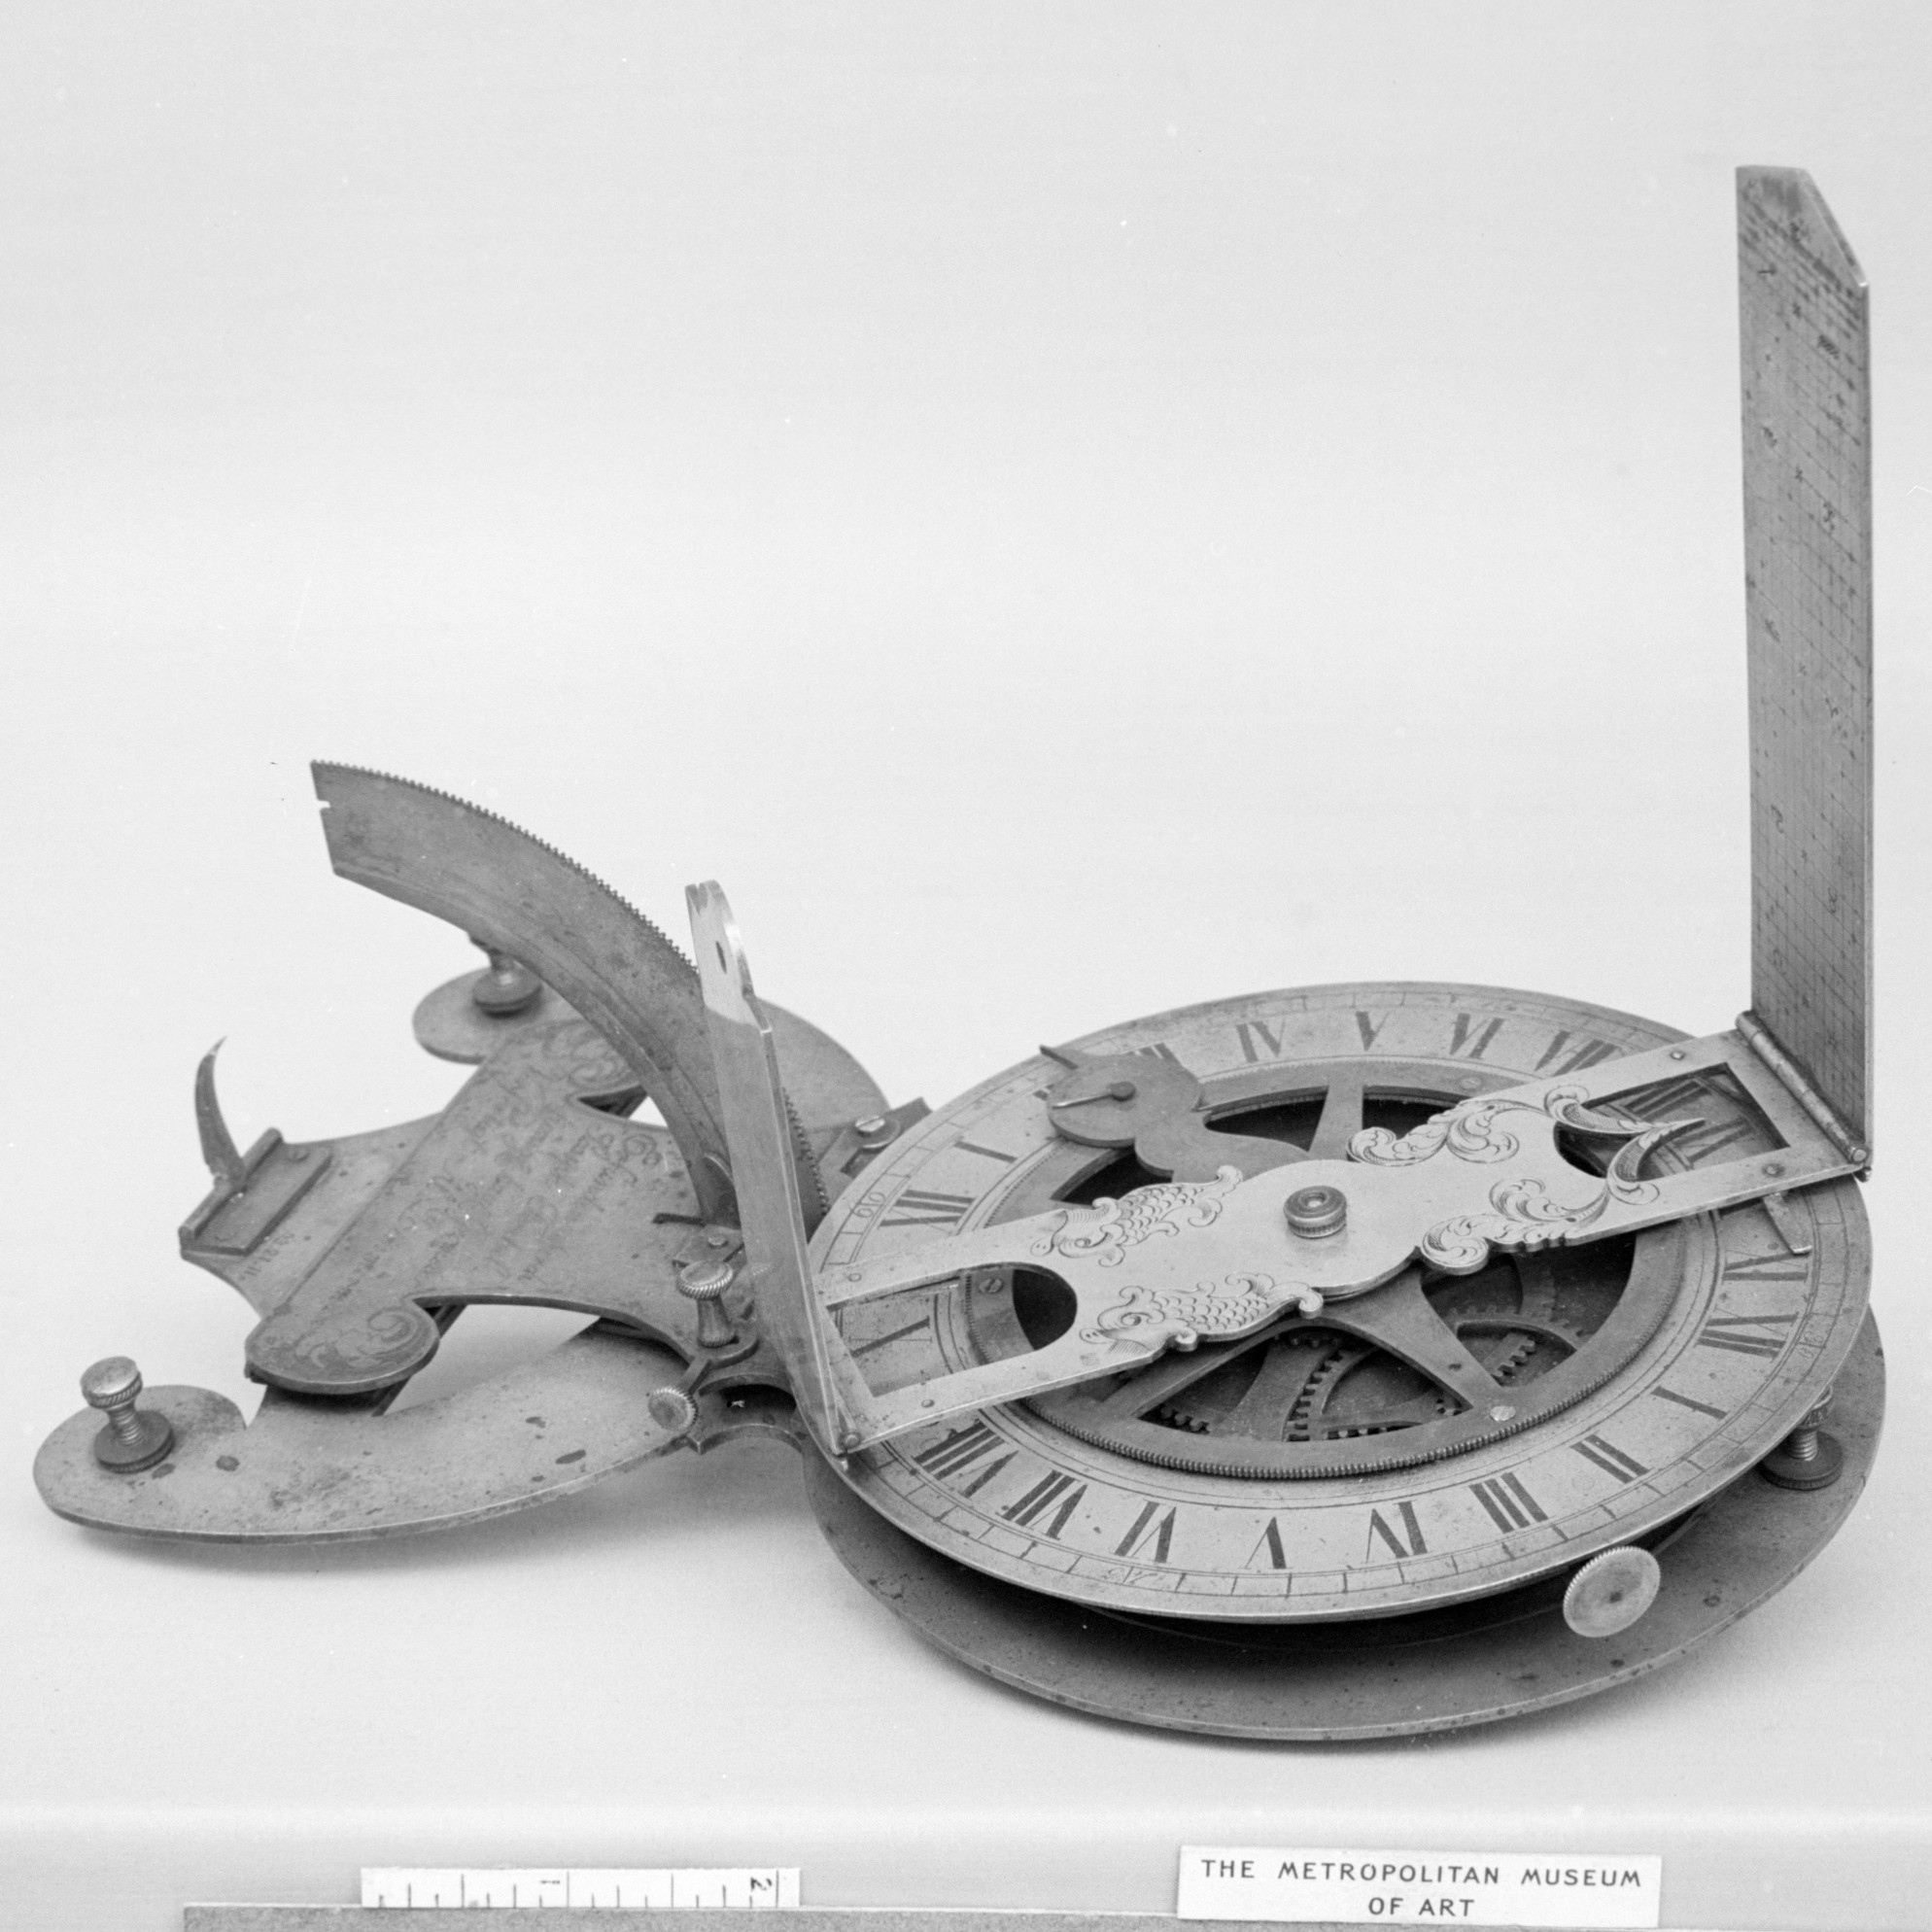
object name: folding compass dial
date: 1801-1833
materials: brass, silver